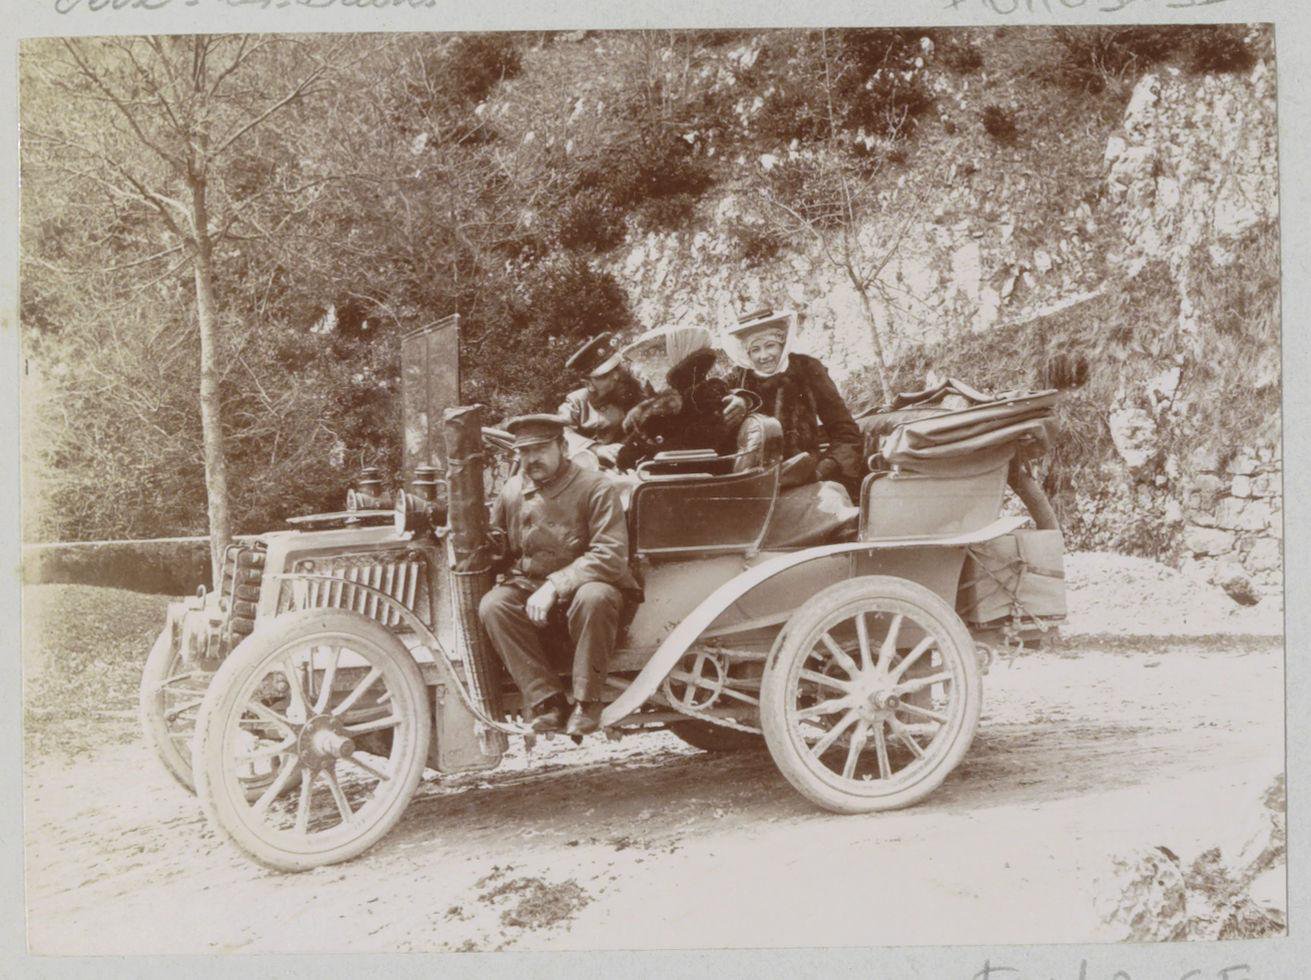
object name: photograph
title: Gezelschap in een automobiel, vermoedelijk in buurt van Aix-les-Bains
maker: delizy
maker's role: manufacturer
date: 1903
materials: paper, photographic support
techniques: gelatin silver print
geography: aix-les-bains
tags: automobile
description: Onderdeel van Fotoalbum van een Franse amateurfotograaf met opnames van uitstapjes in Frankrijk, Spanje, België, Luxemburg en Nederland, de eerste automobielen en autoraces.